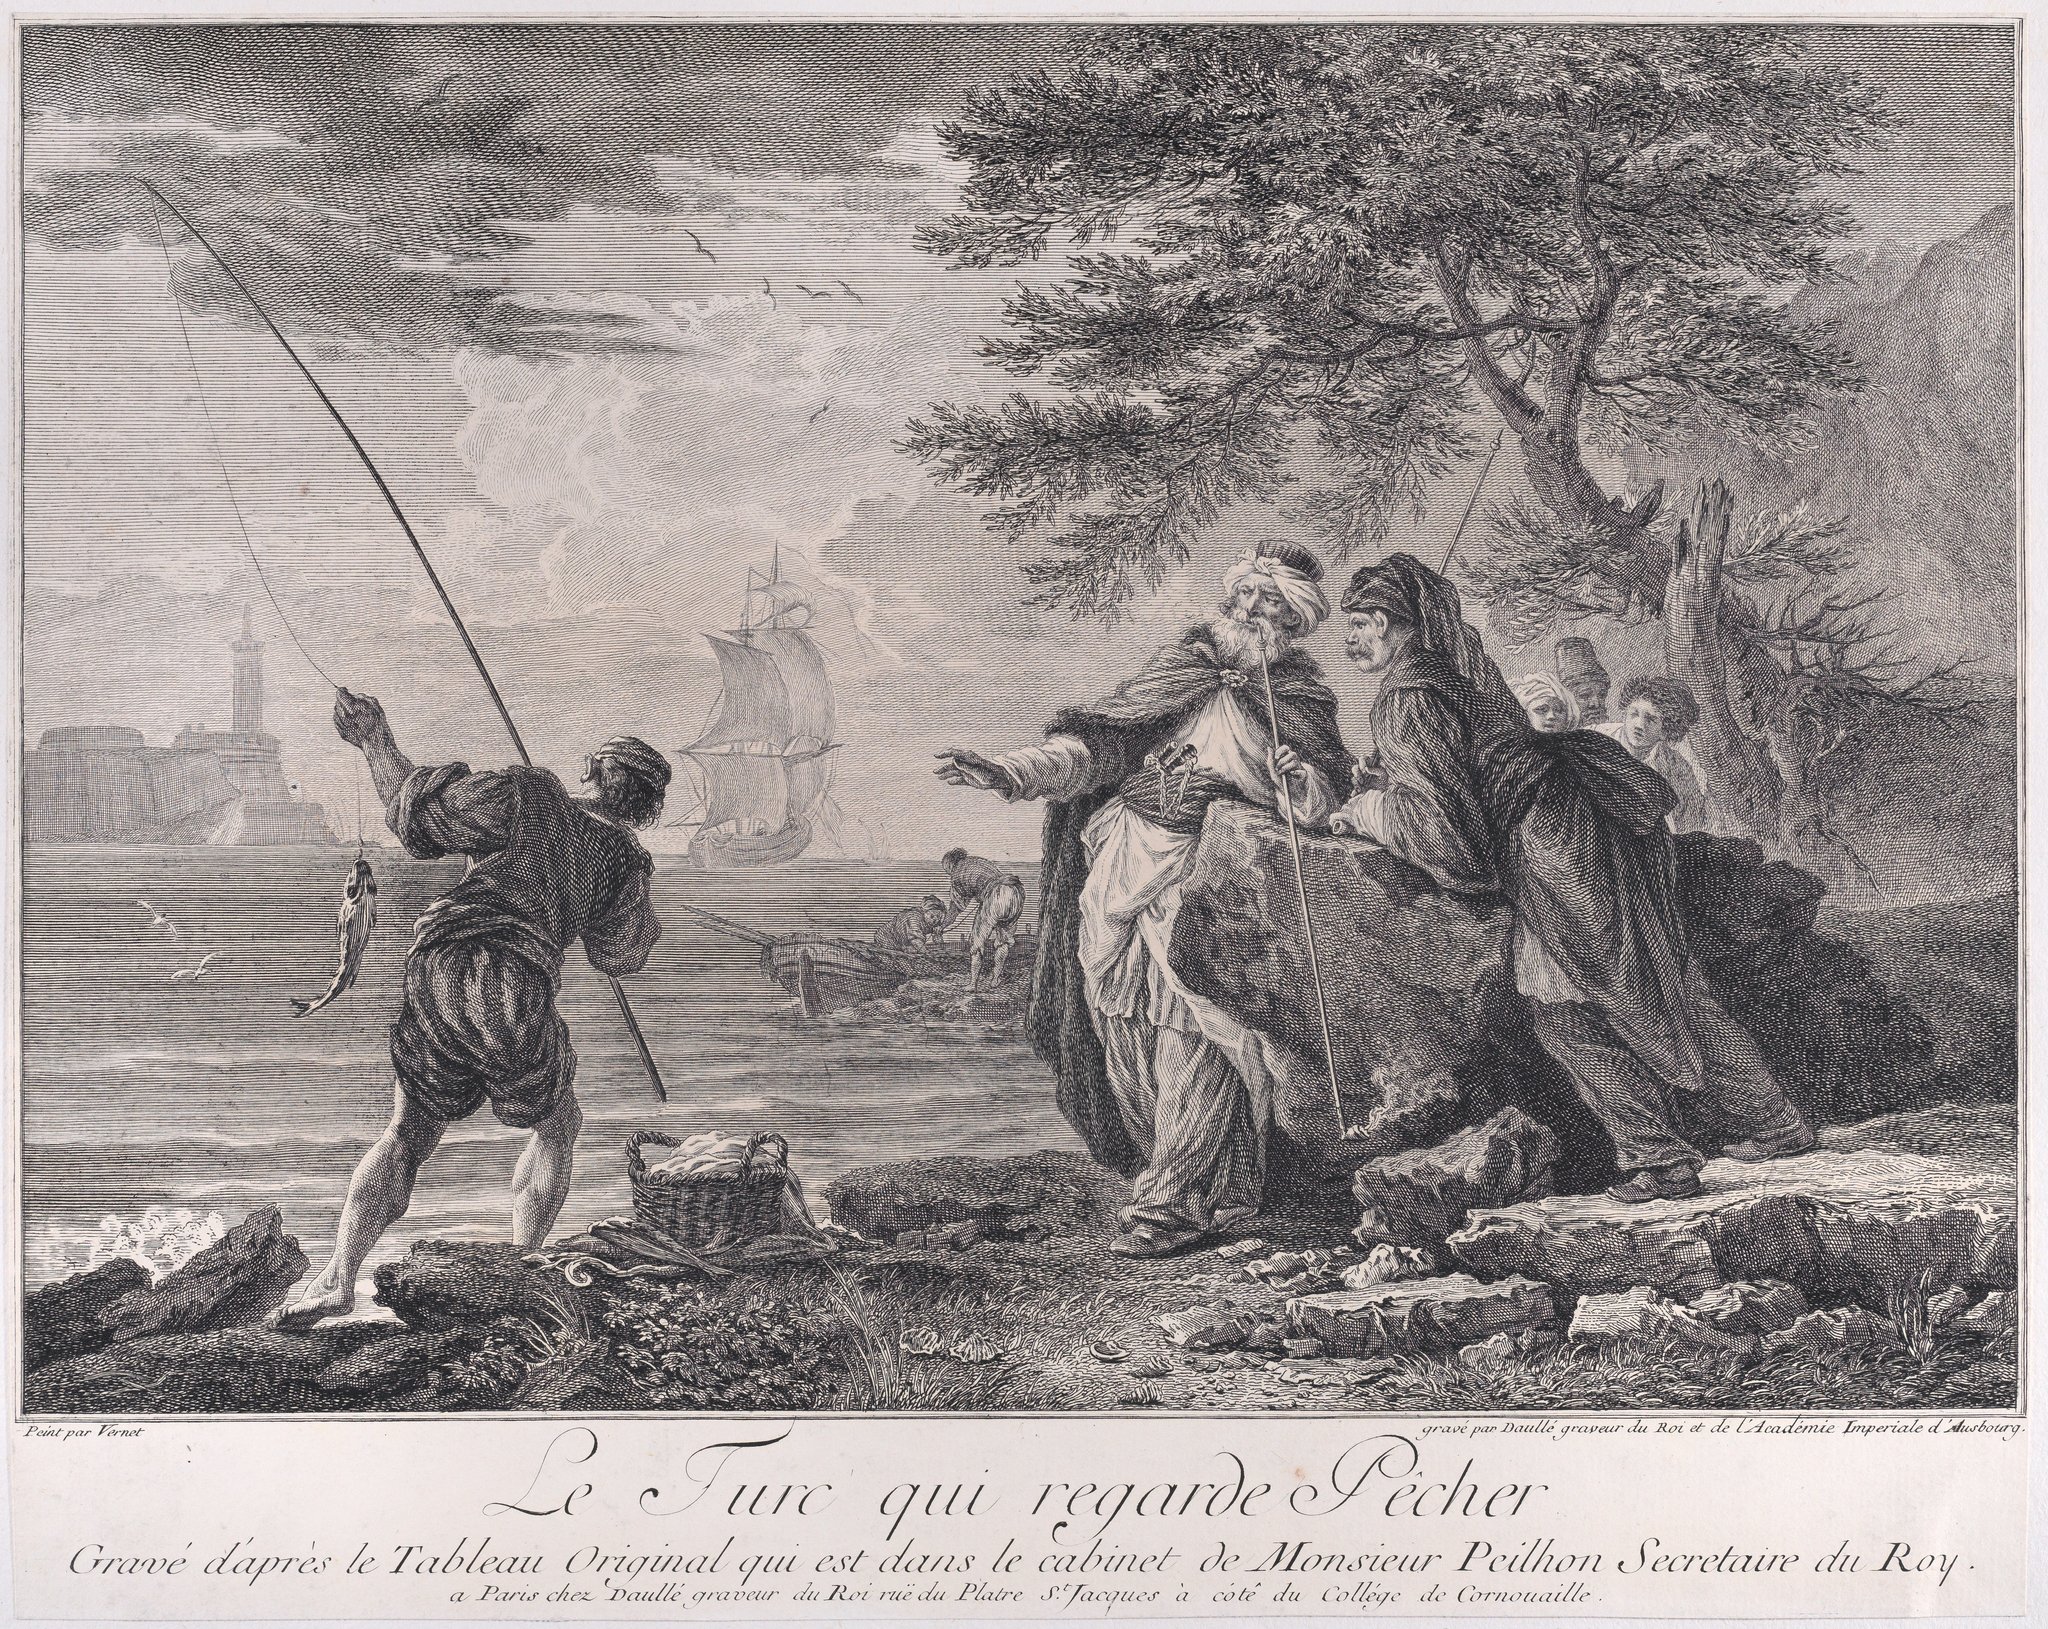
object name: print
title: The Turc Who Watches Fishing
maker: joseph vernet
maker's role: artist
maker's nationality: french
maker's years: 1714-1789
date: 1720-1760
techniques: engraving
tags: men,fishing